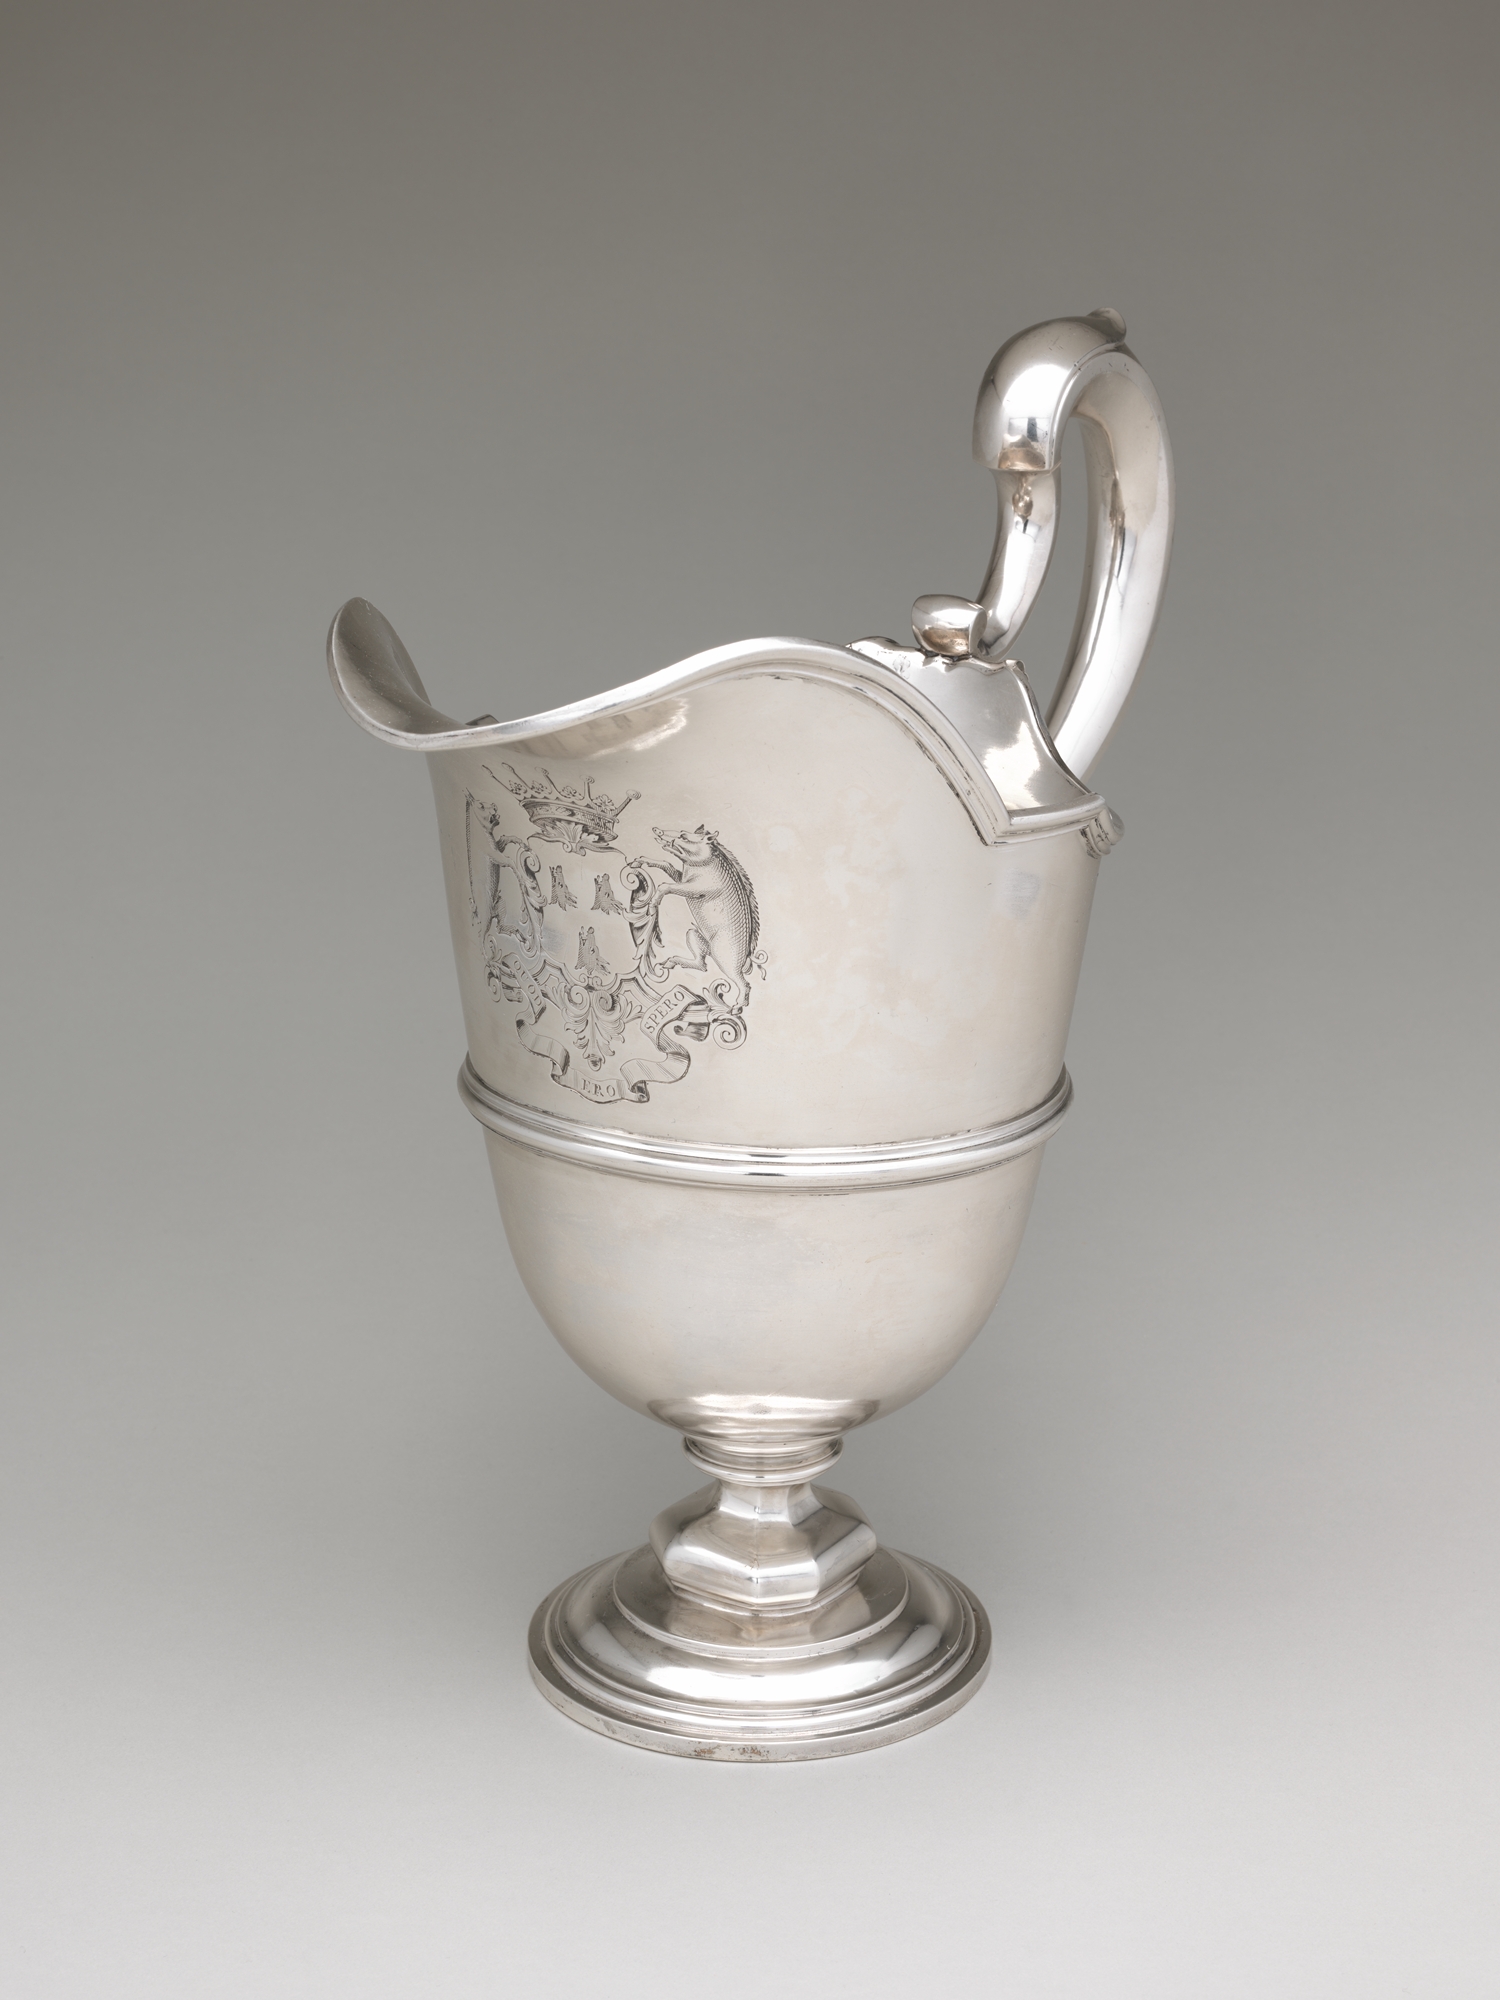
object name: ewer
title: Ewer (one of a pair)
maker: peter archambo i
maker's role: maker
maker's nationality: british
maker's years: 1659-1759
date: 1740-1741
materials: silver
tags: coat of arms